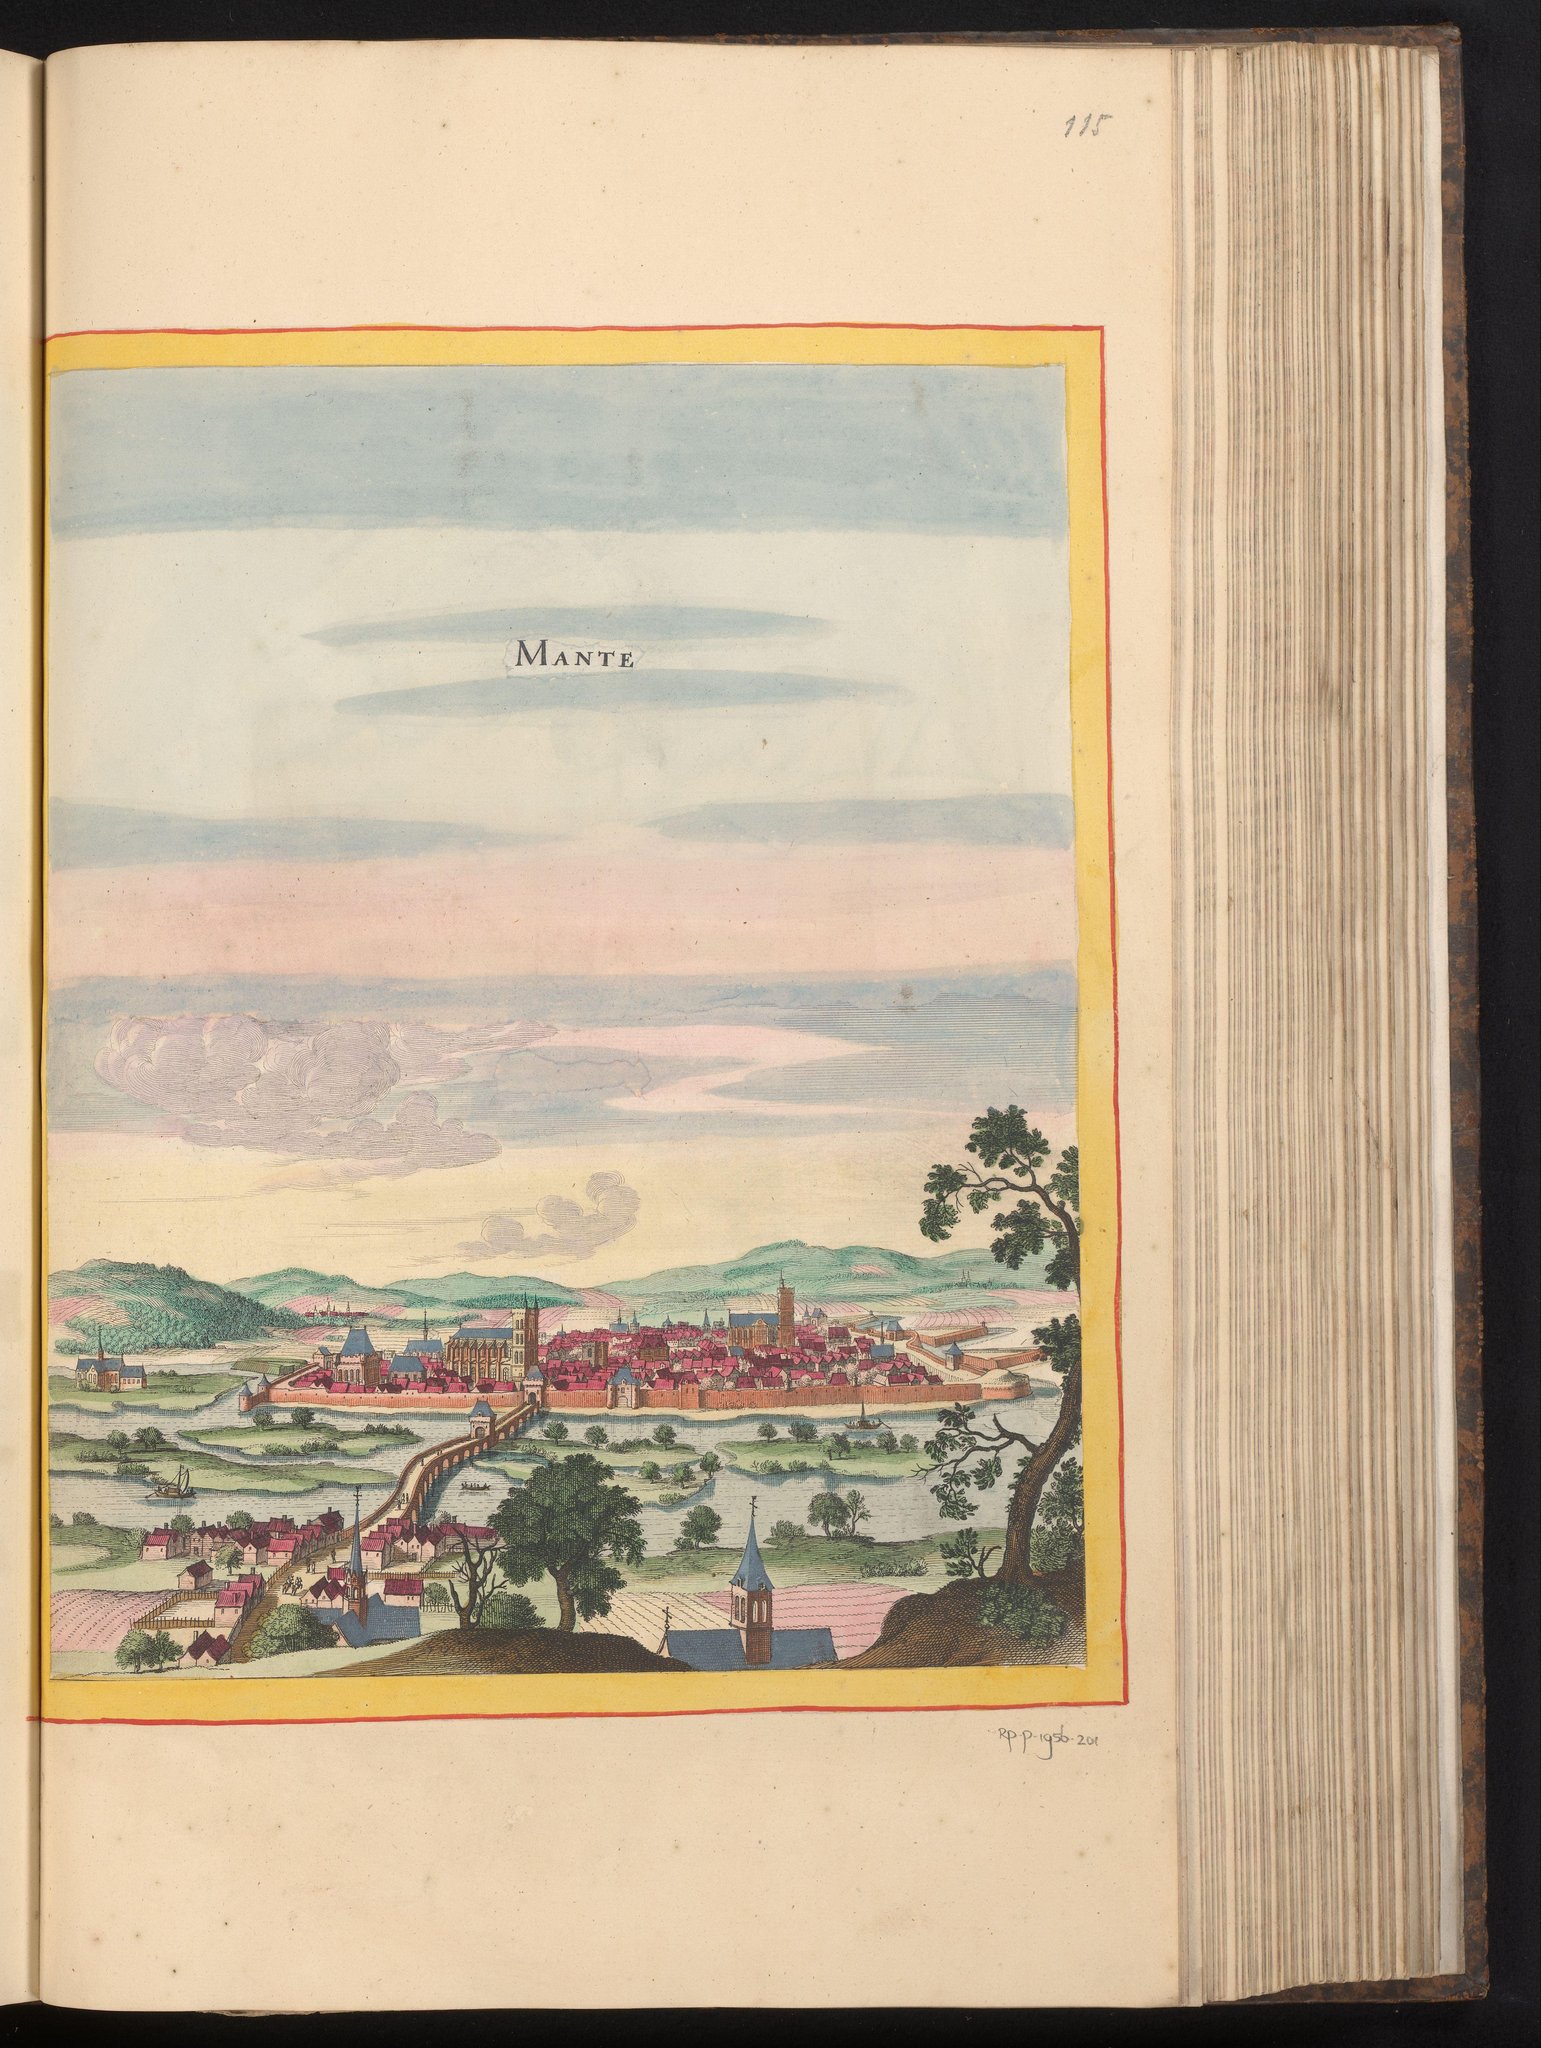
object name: print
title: Mante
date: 1657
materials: paper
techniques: engraving, etching, hand coloring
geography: the hague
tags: city-view in general; 'veduta'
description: Prent uit: Zeiller, Martin. Topographia Galliae. 13 dln. Frankfurt: Caspar Merian, 1657, dl. 7, na p. 38. De titel is uit de originele prent gesneden. Boven de gravure is een deel lucht en wolken (bij)geschilderd, waarin de titel gelijmd is.